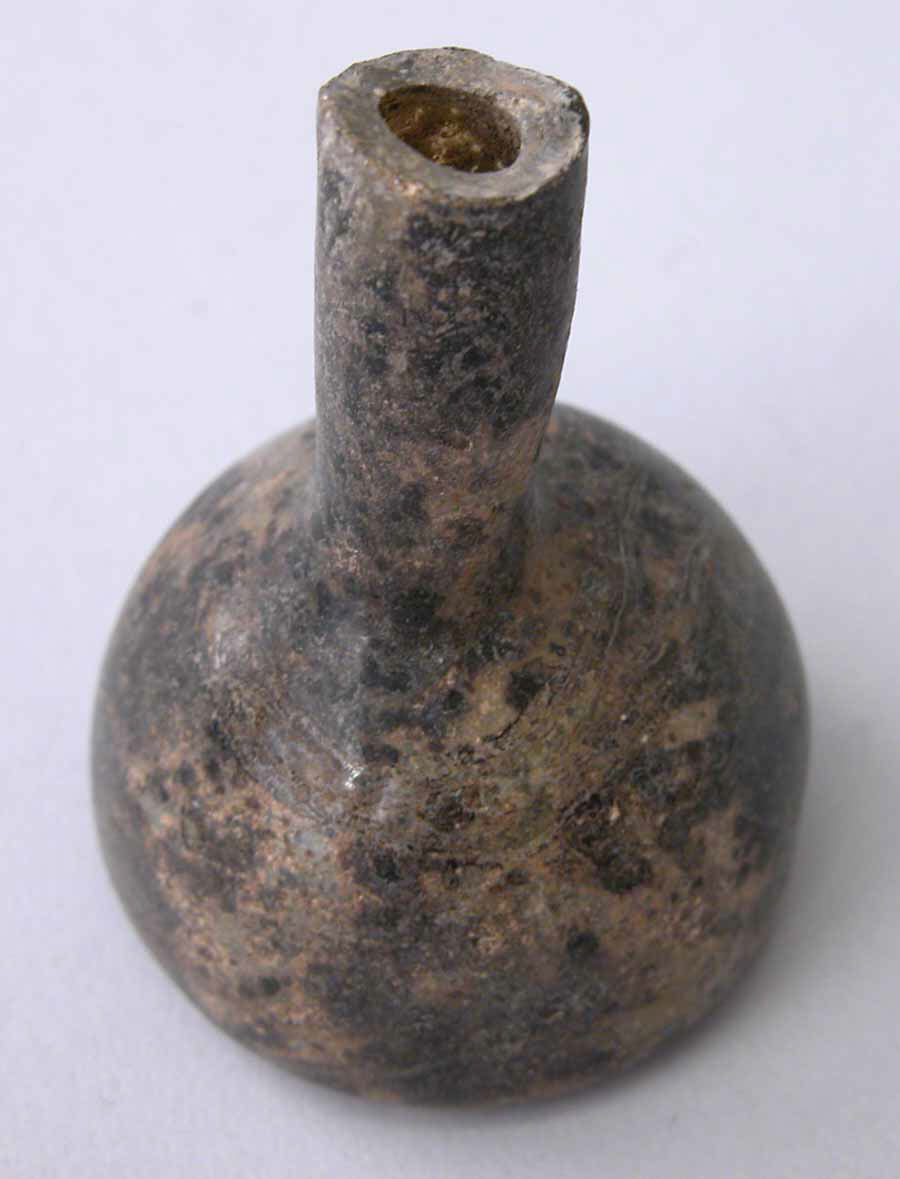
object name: bottle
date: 601-800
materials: glass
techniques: glassblowing, tooling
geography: iraq